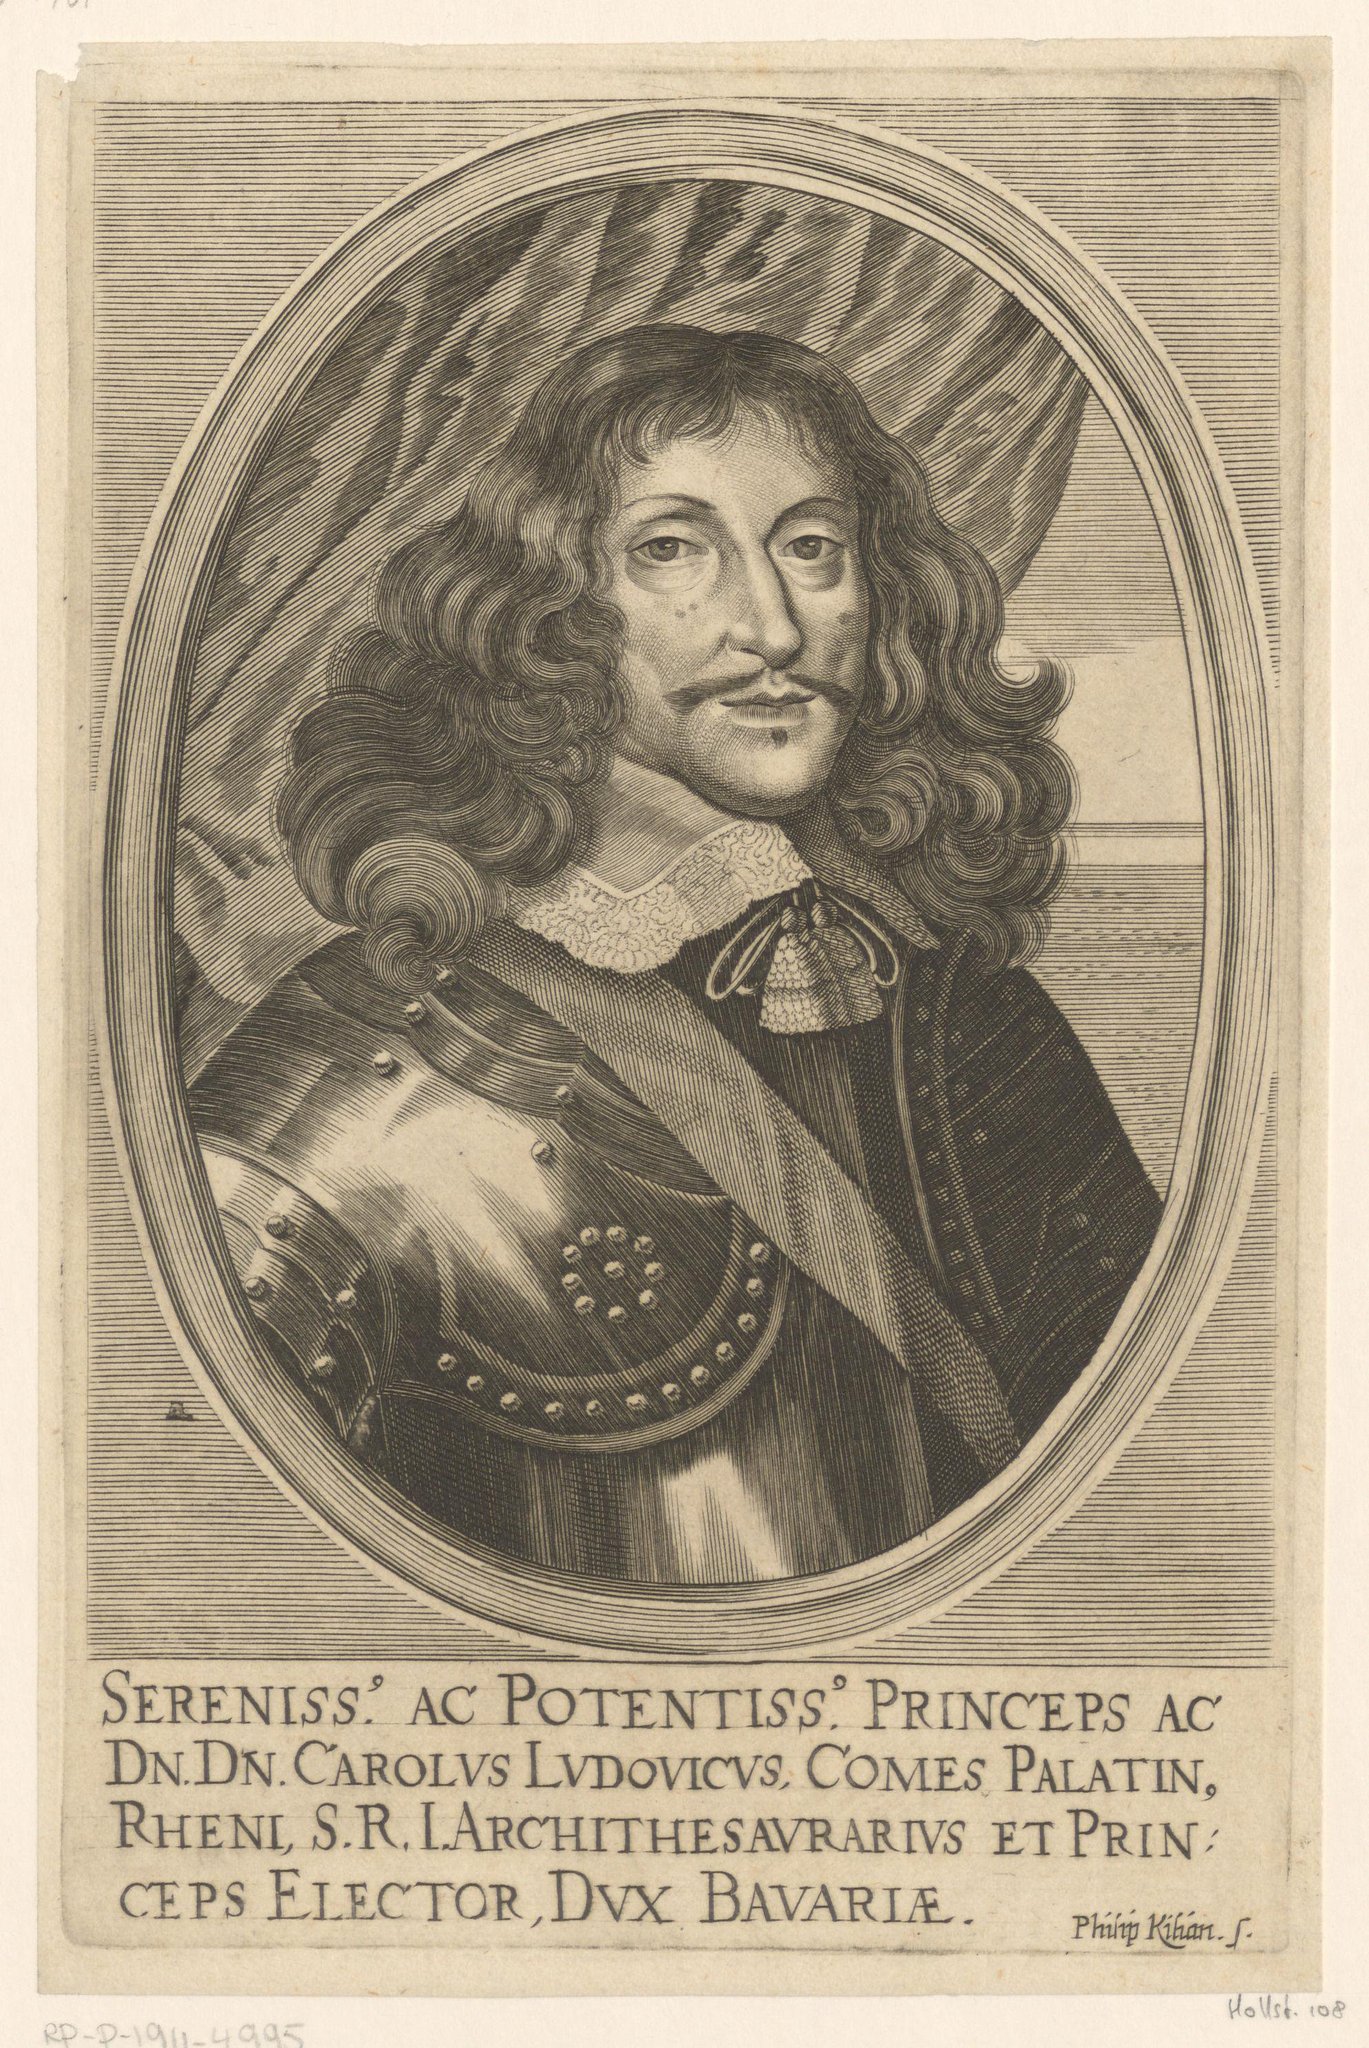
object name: print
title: Portret van Carl Ludwig van de Palts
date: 1638-1693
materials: paper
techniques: engraving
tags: historical persons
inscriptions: collector's mark: Lugt 2228